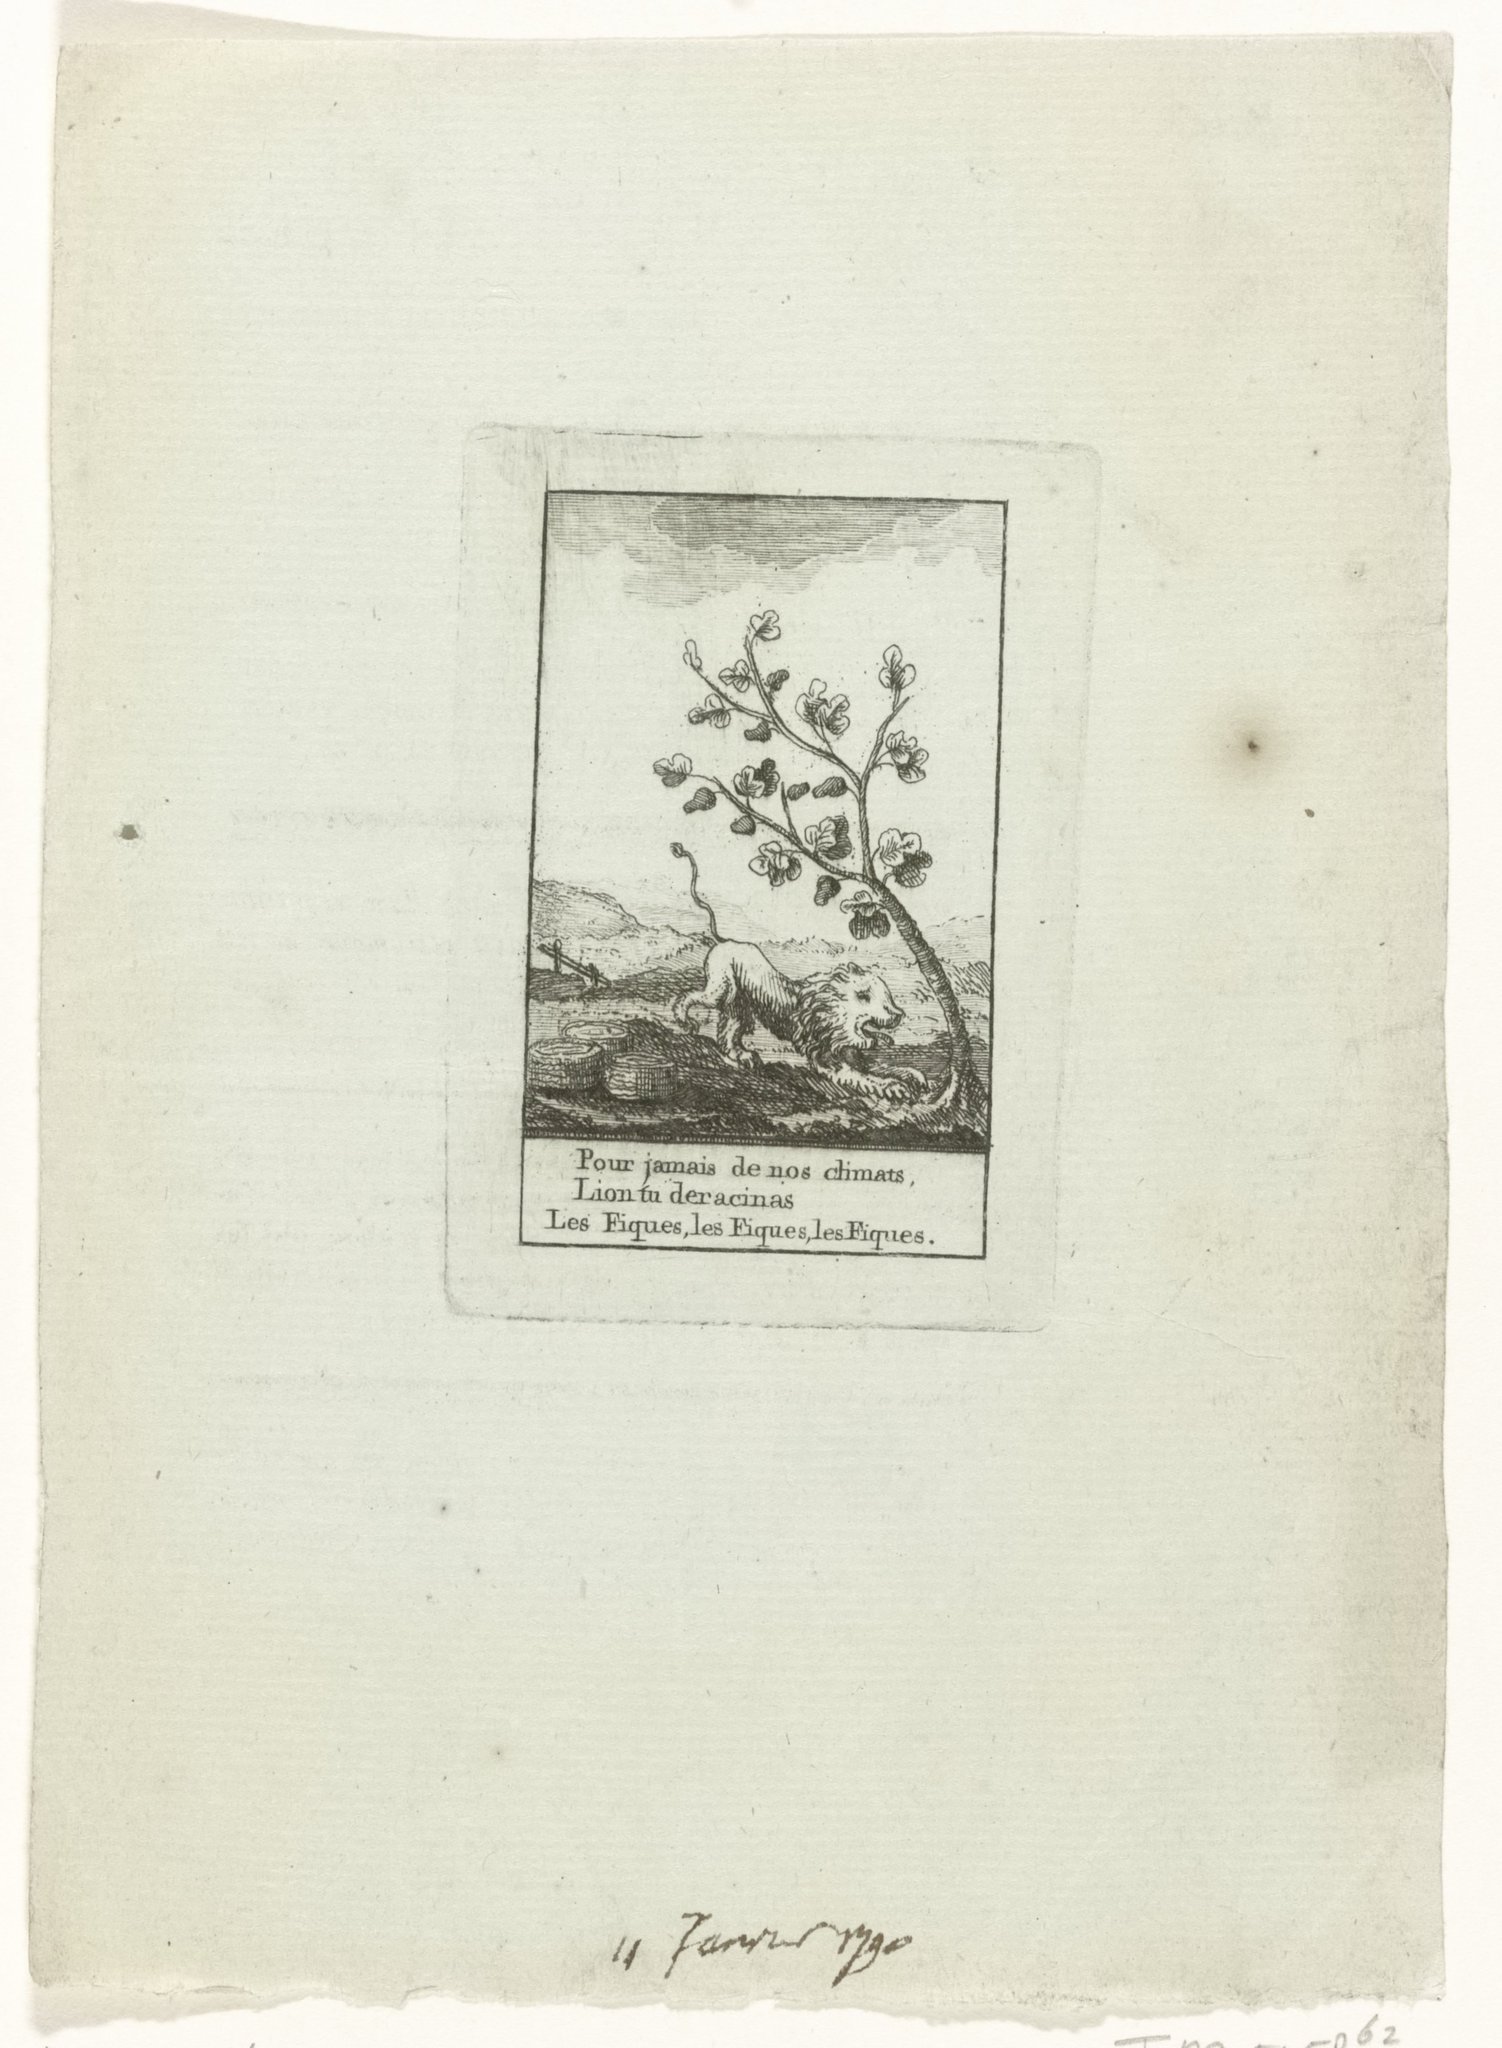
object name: print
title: Leeuw gravend bij een vijgenboom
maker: Anonymous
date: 1787-1790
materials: paper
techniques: etching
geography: southern netherlands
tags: trees: fig-tree, brabant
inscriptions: collector's mark: Lugt 2228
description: Spotprent waarin de Brabantse leeuw graaft in de grond aan de voet van een vijgenboom. Hierbij de datum 11 januari 1790 met de hand geschreven. Onderdeel van een grote groep van prenten betrekking hebbend op de gebeurtenissen van de Brabantse Omwenteling en de periode 1787-1790.